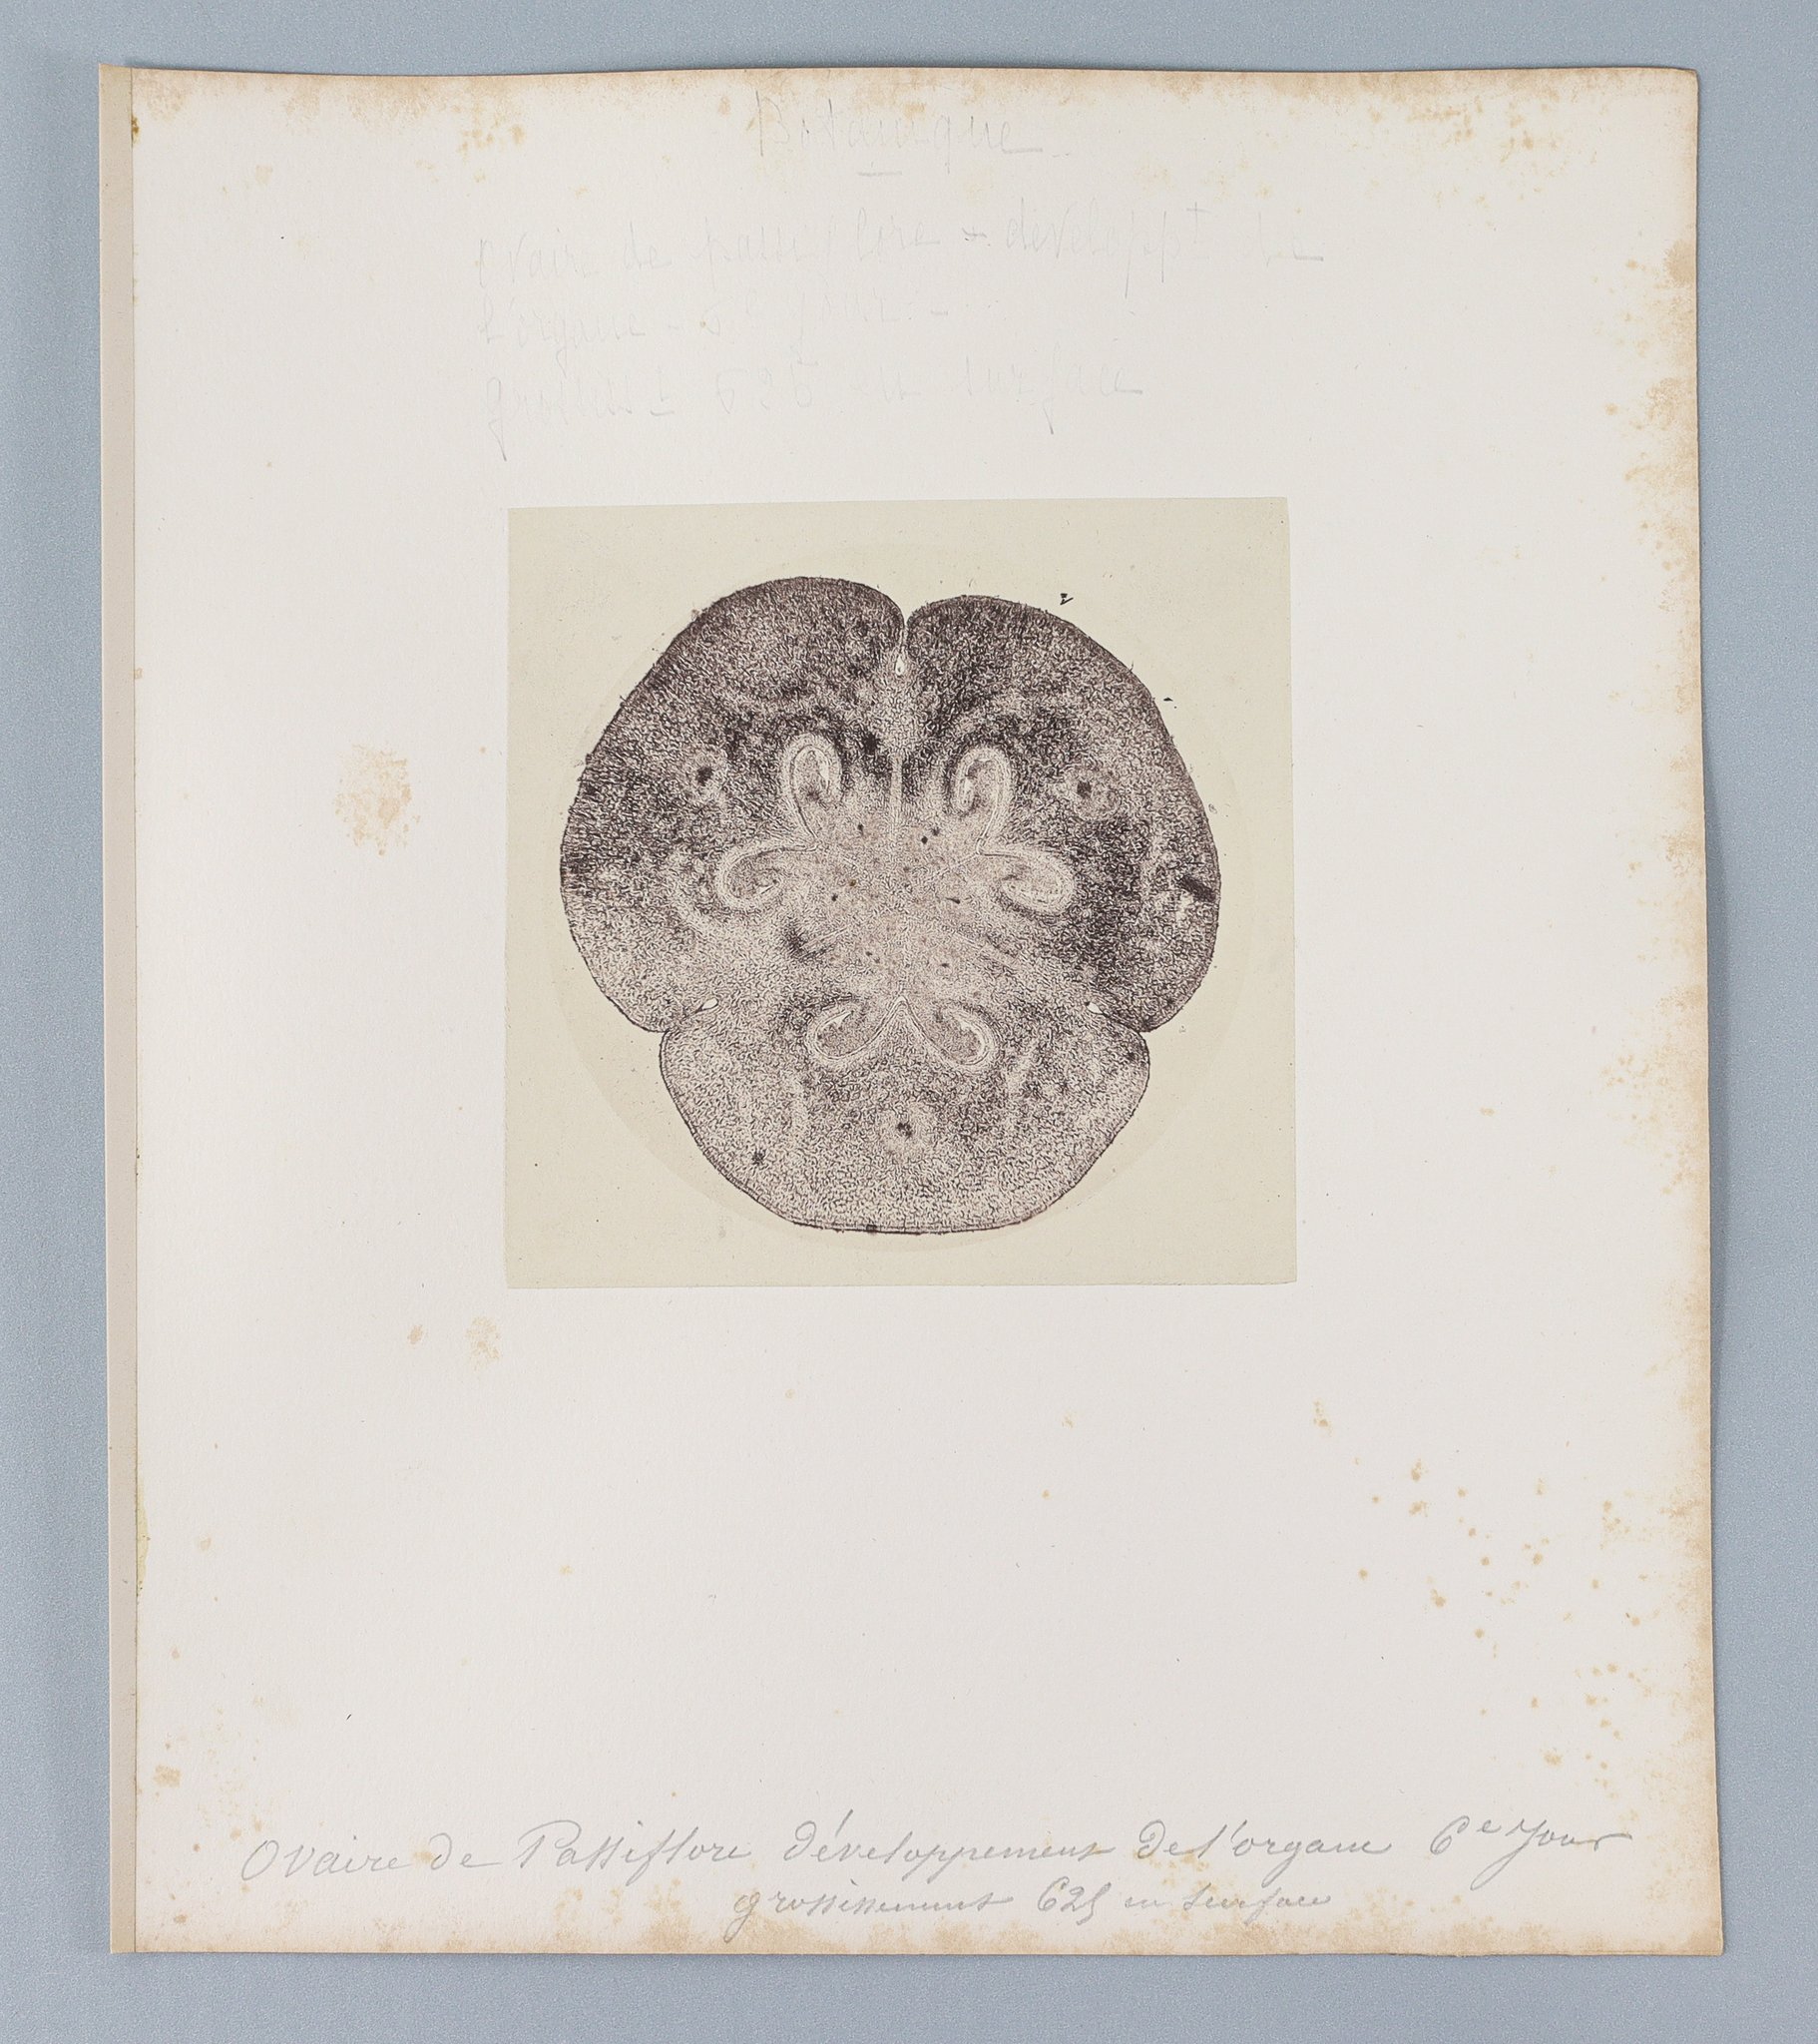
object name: photograph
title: [Untitled]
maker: auguste-adolphe bertsch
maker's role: artist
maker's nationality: french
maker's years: 1813-1871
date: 1853-1857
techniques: salted paper print